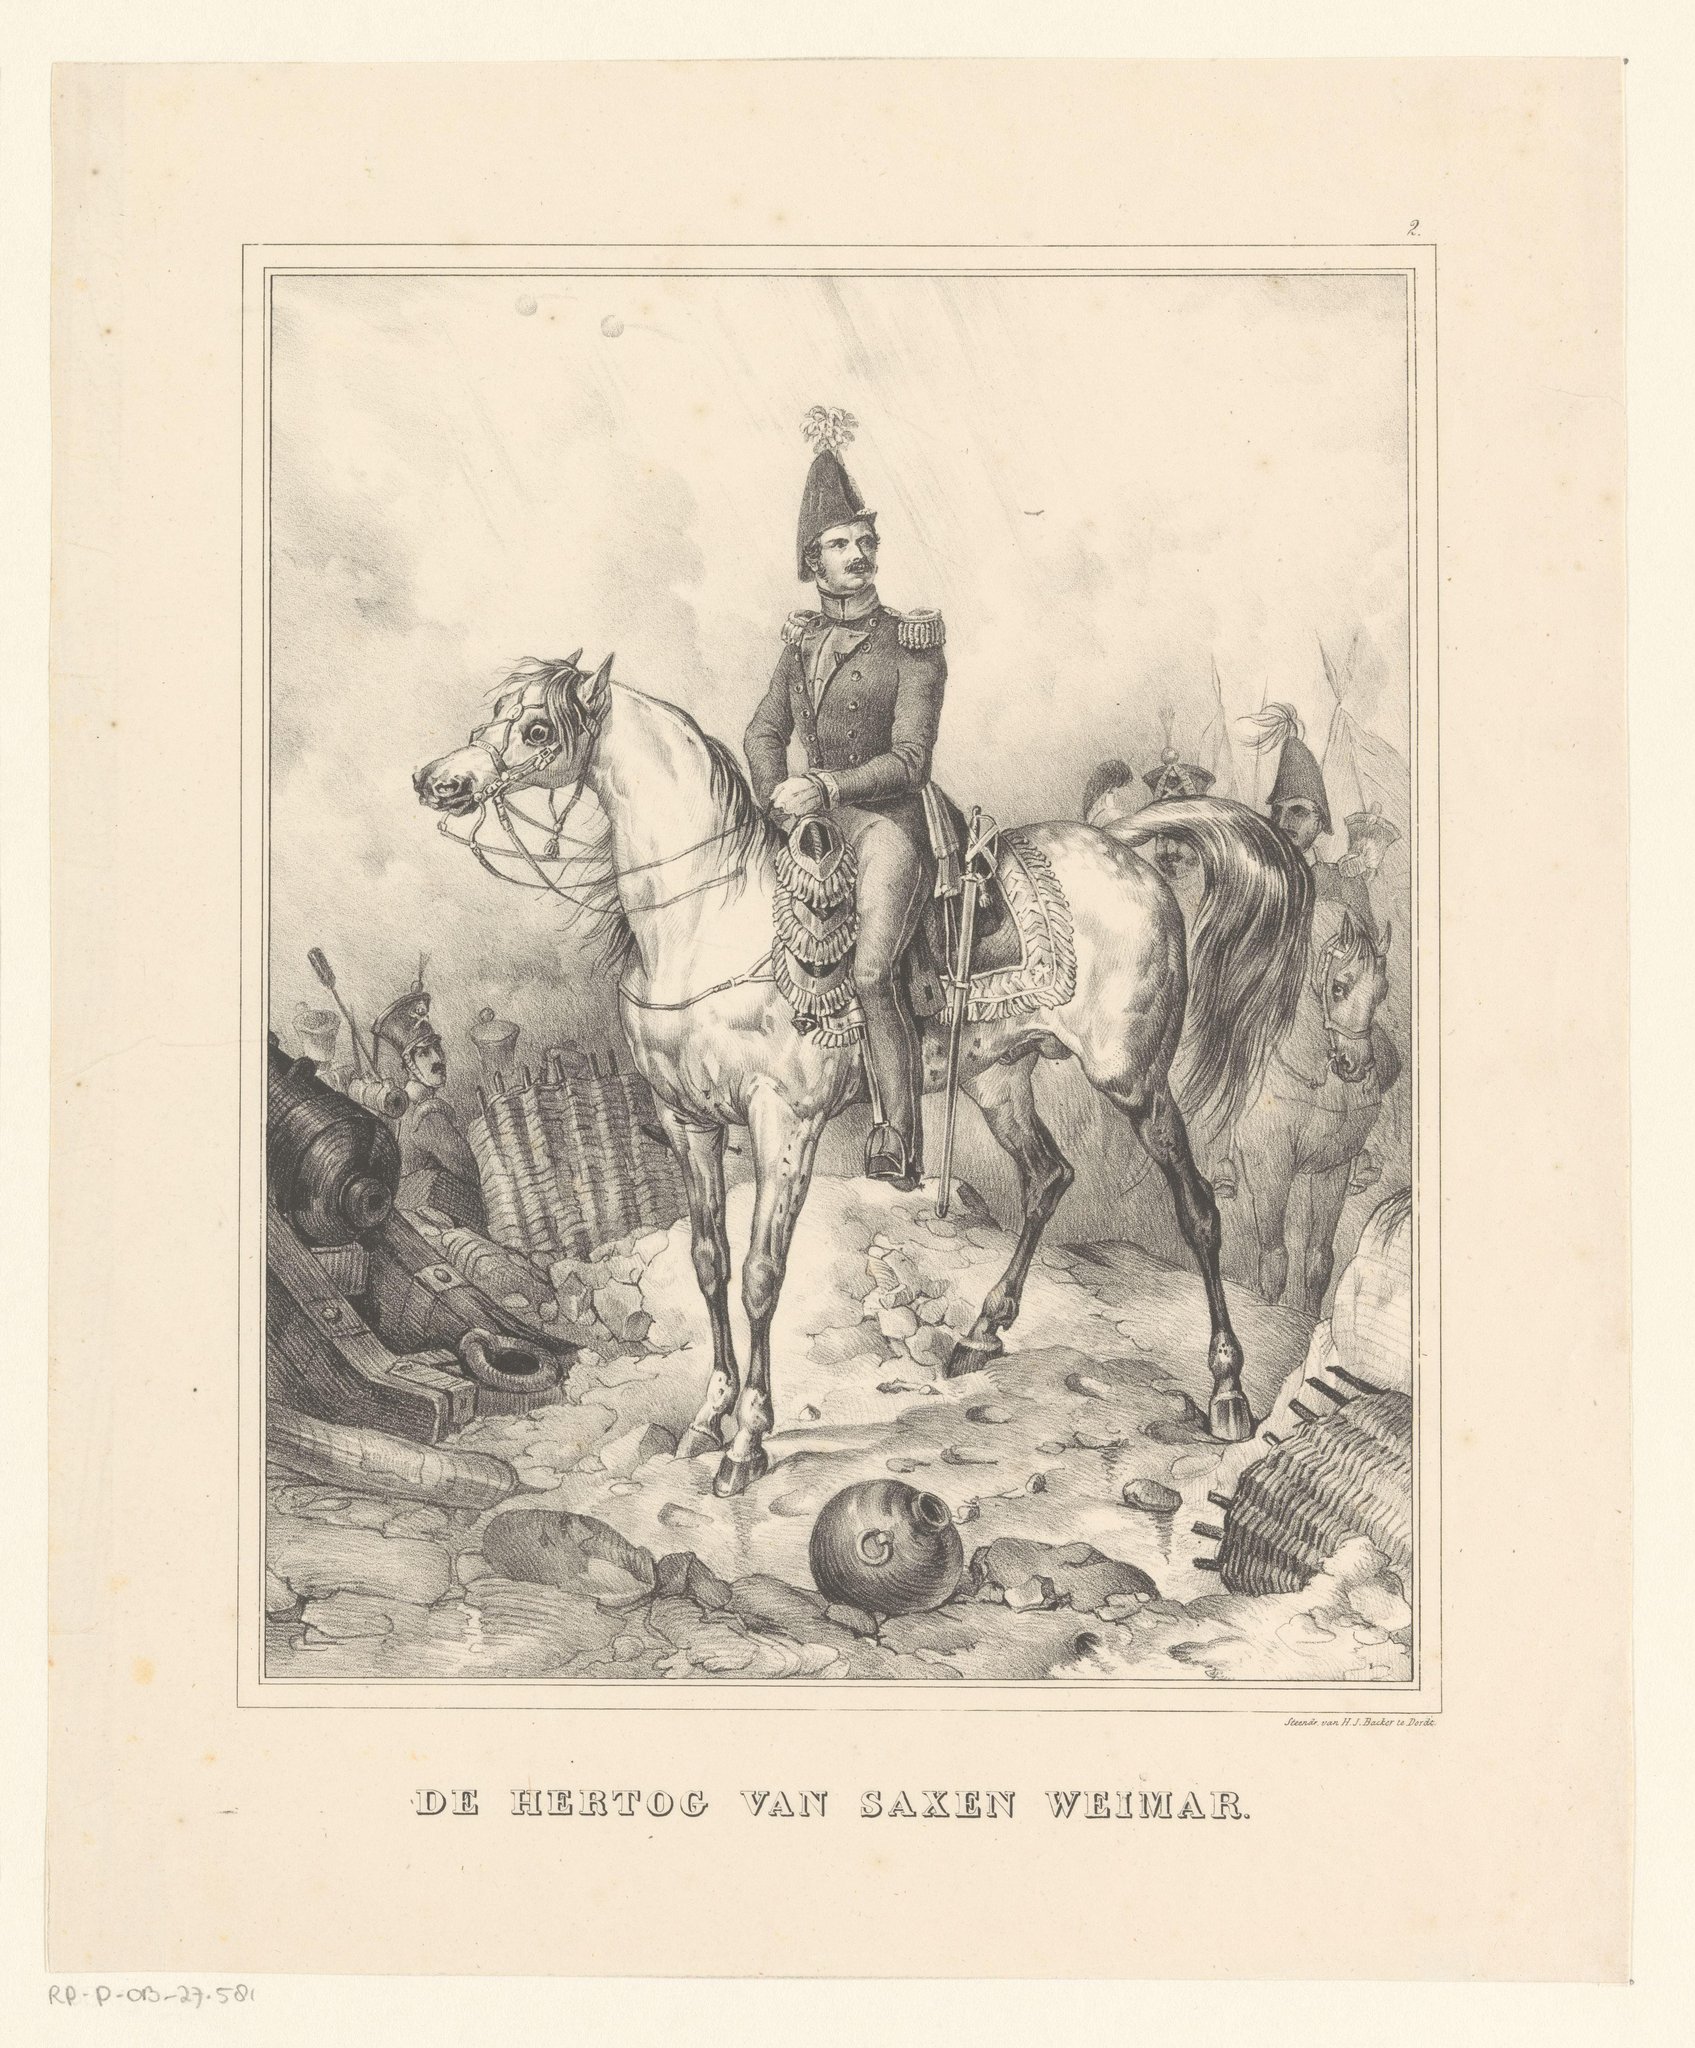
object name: print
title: Ruiterportret van Karel Bernhard, hertog van Saxen Weimar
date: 1822-1845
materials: paper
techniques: lithograph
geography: dordrecht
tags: karel bernhard (hertog van saksen-weimar-eisenach), equestrian state-portrait, war (+ during the battle)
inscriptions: collector's mark: Lugt 2228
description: Ruiterportret op een slagveld. Rondom de geportretteerde staan soldaten en een kanon. Onder het portret zijn titel.